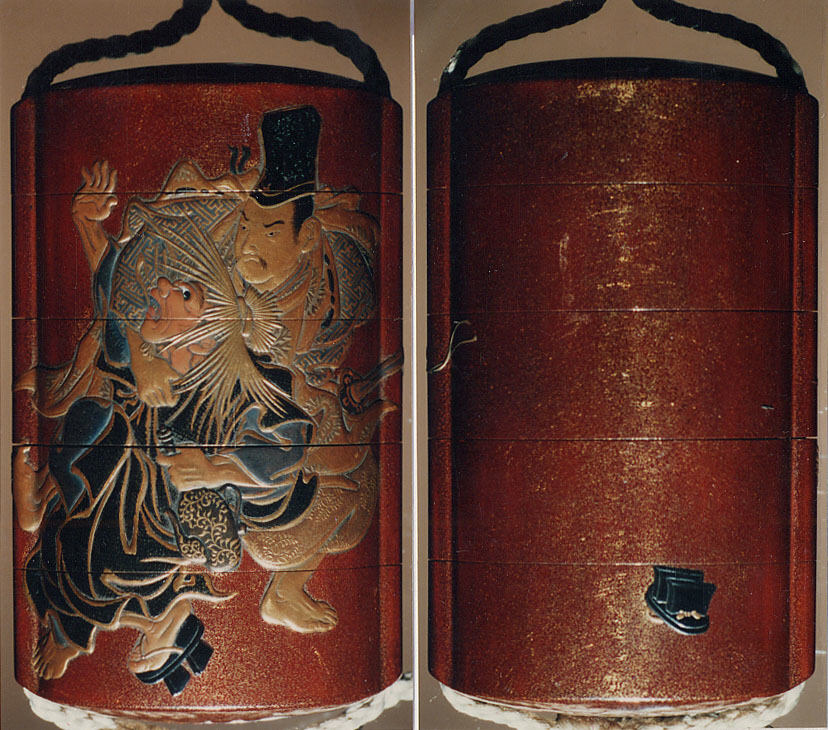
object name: inrō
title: Case (Inrō) with Design of Tadamori Fighting with the Oil Thief (obverse); Sandal (Geta) which was Lost during the Fight (reverse)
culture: japanese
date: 1801-1900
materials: gold, lacquer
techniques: fundame, hiramakie, maki-e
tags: men